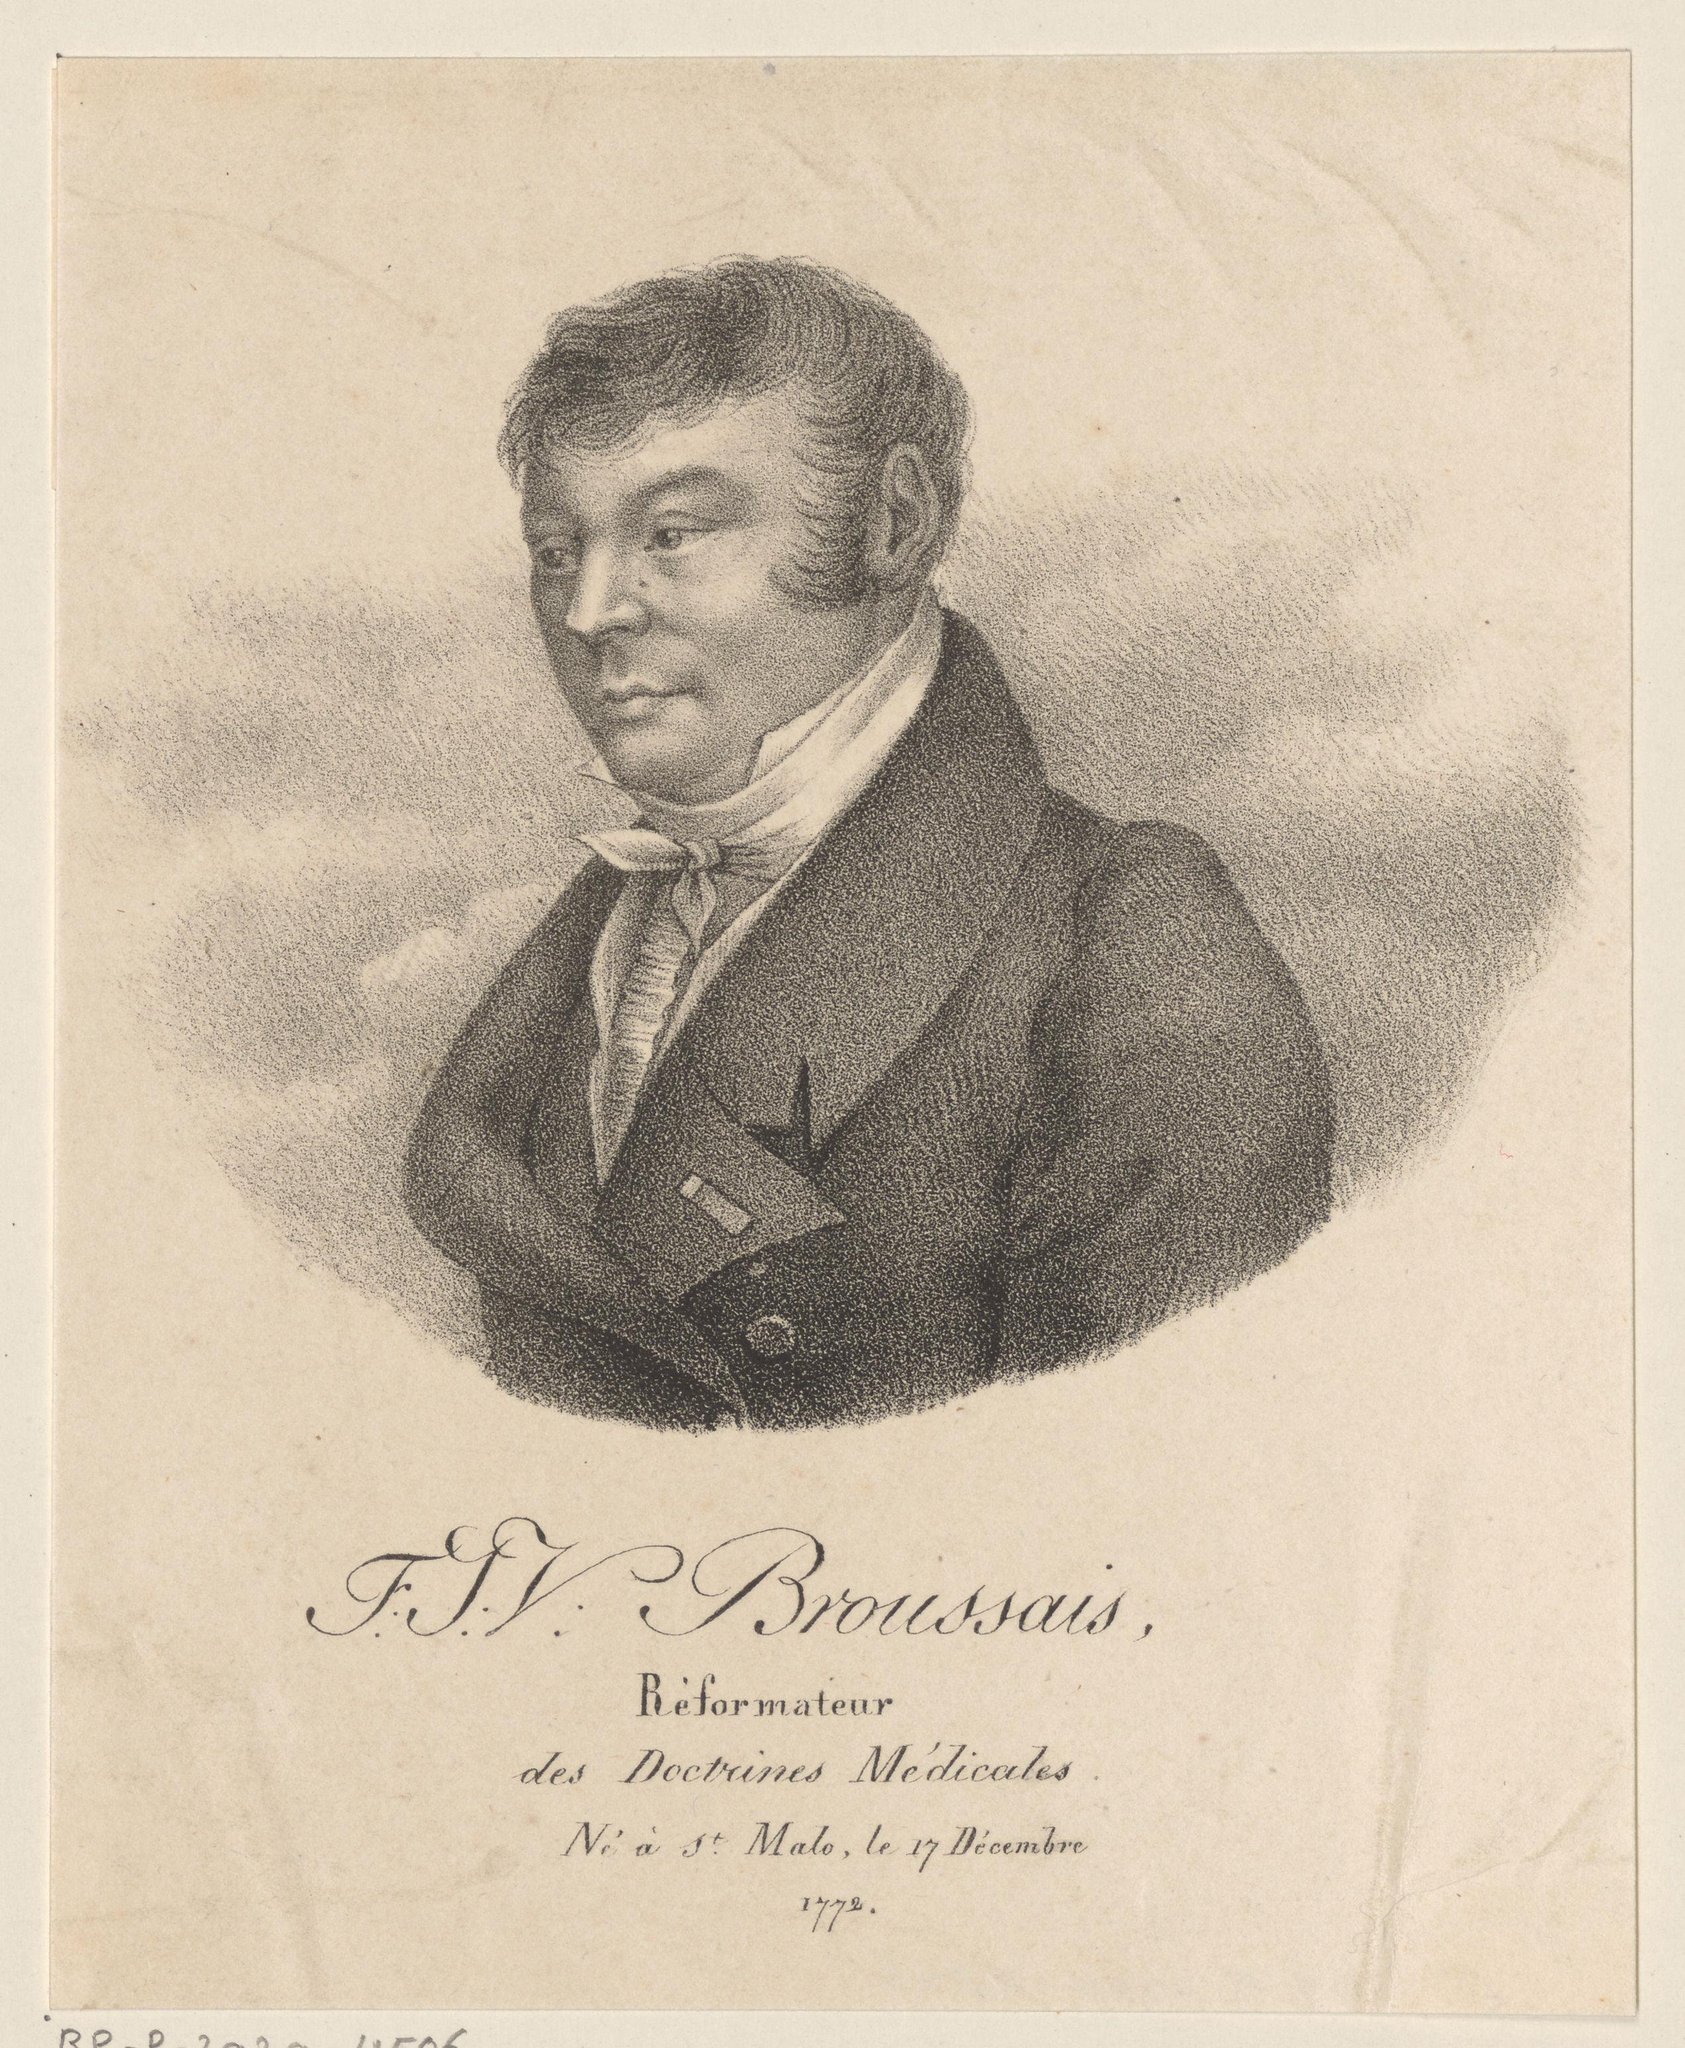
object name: print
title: Portret van François Broussais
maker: Anonymous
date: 1800-1849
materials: paper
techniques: lithograph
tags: historical persons, physician, doctor